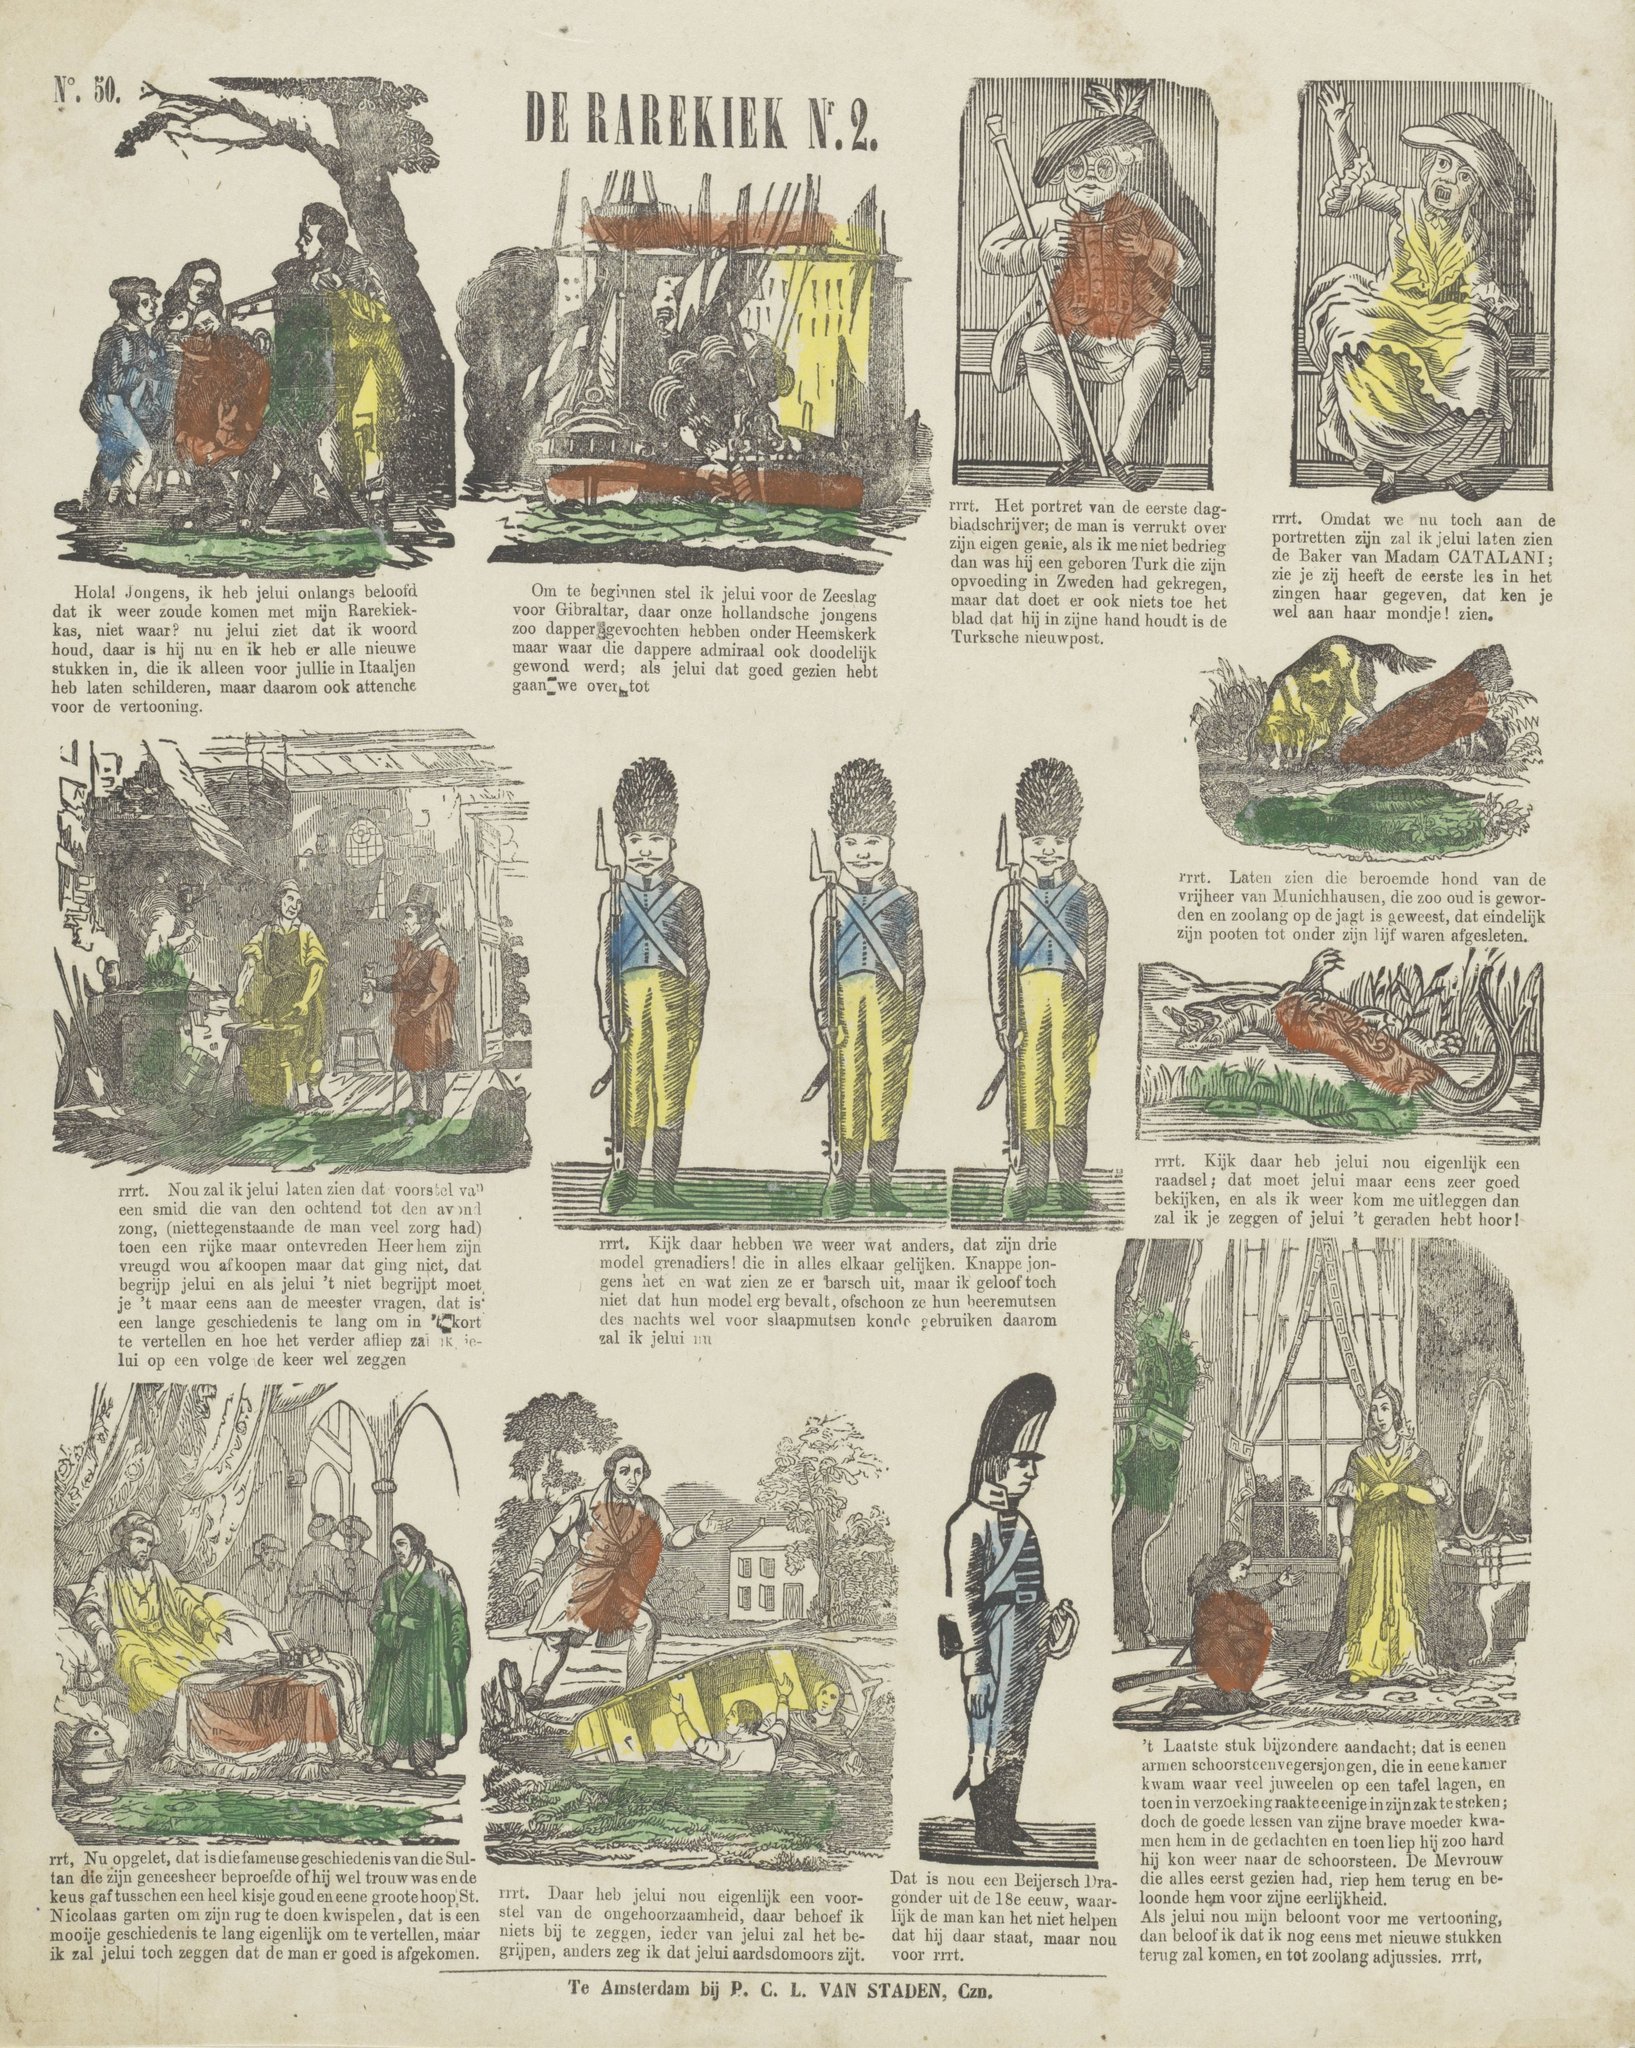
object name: print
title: De rarekiek nr. 2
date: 1850-1870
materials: paper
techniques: colour, letterpress printing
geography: netherlands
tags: animals, human types, characters (human types), the soldier; the soldier's life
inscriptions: collector's mark: Lugt 2760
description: Blad met 13 voorstellingen van verschillende aard, zoals voorstellingen van soldaten, van figuren en van dieren. Onder elke afbeelding een onderschrift. Genummerd linksboven: No. 50.